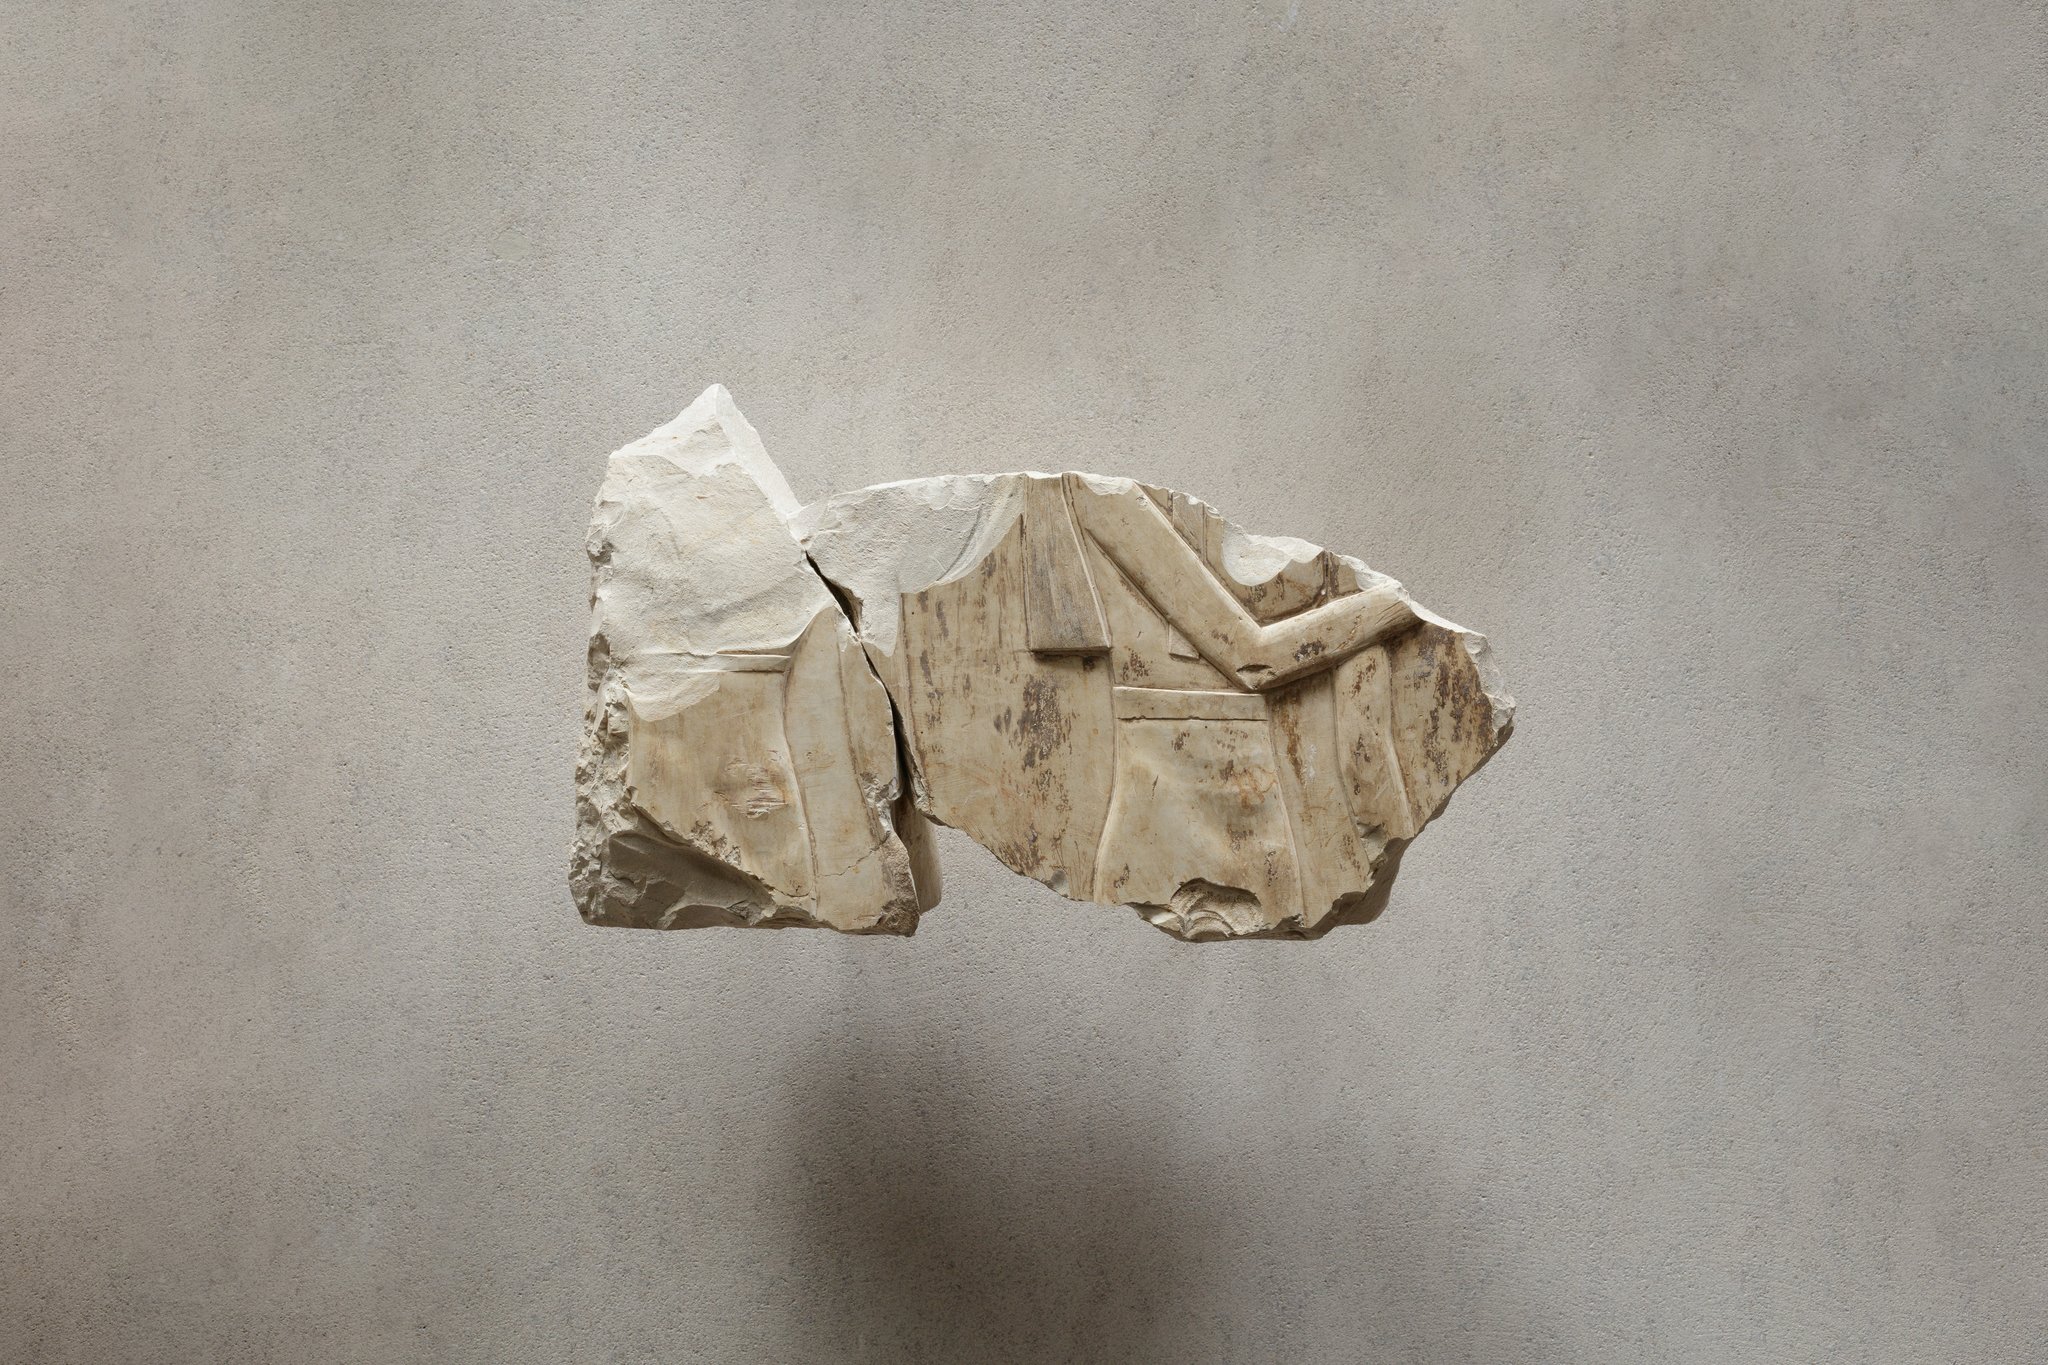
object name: relief, female attendant, neferu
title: Relief from the tomb of Queen Neferu: two female attendants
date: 2051-2030 BCE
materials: limestone, paint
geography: egypt